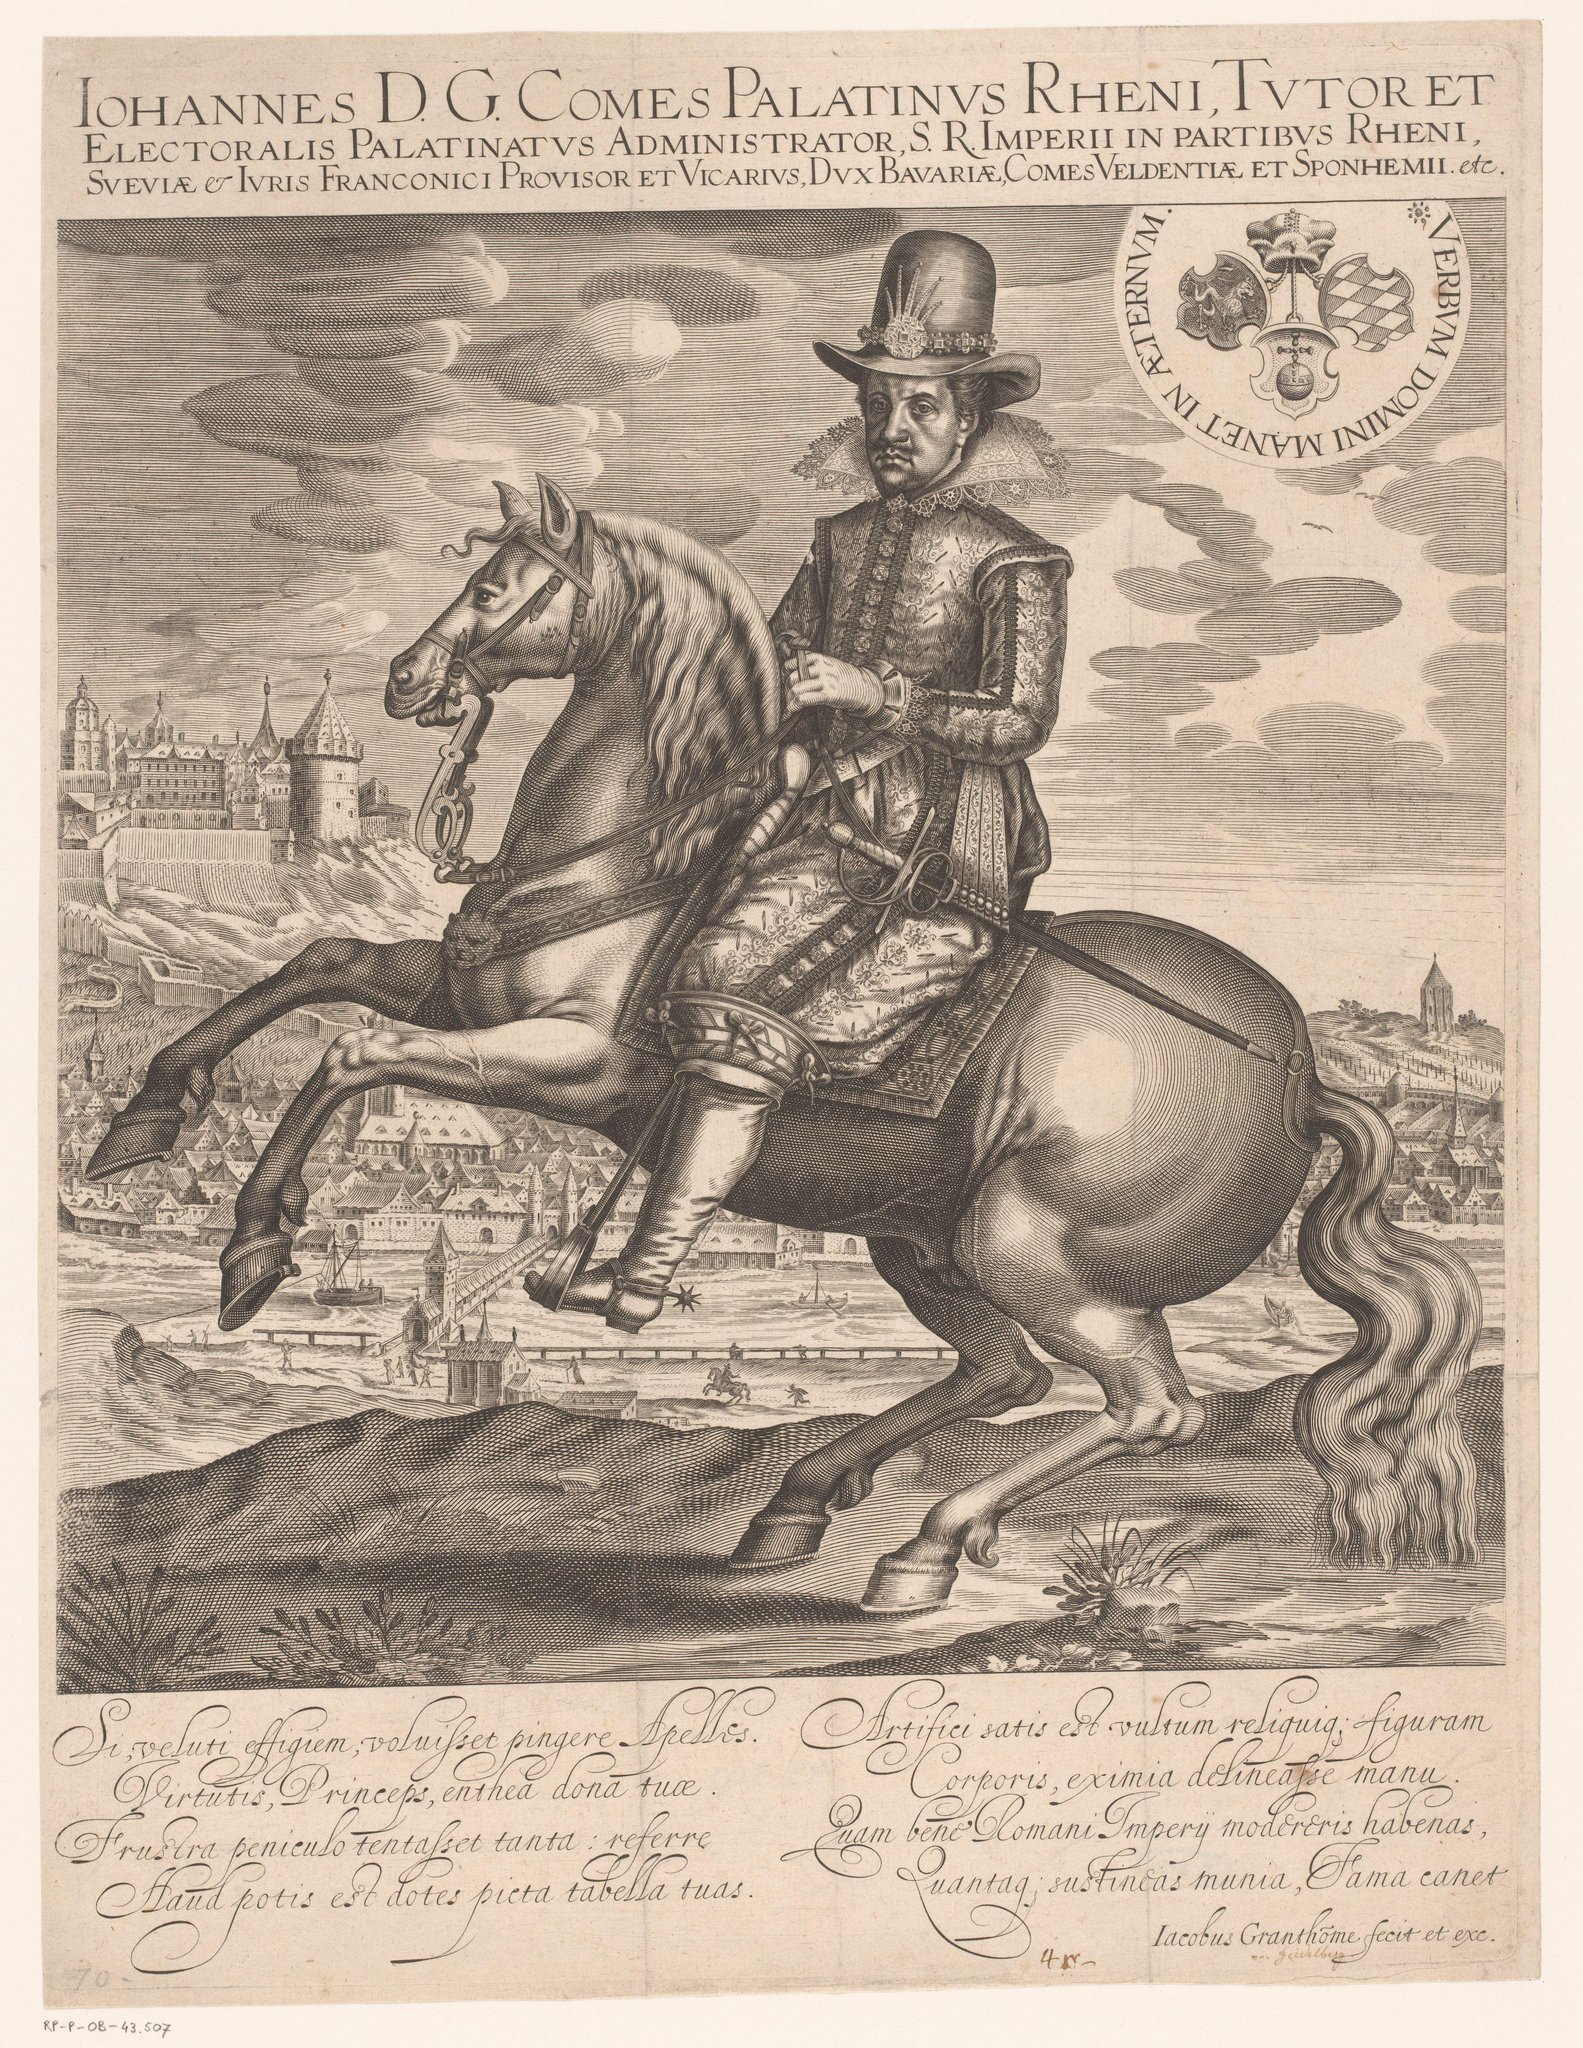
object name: print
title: Ruiterportret van Johan Casimir, paltsgraaf aan de Rijn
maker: jacques granthomme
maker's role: print maker, publisher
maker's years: 1550-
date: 1588-1622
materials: paper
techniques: engraving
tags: historical persons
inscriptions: inscription: ‘Amman[...]’, inscription: ‘4- Heidelberg’, collector's mark: Lugt 2228